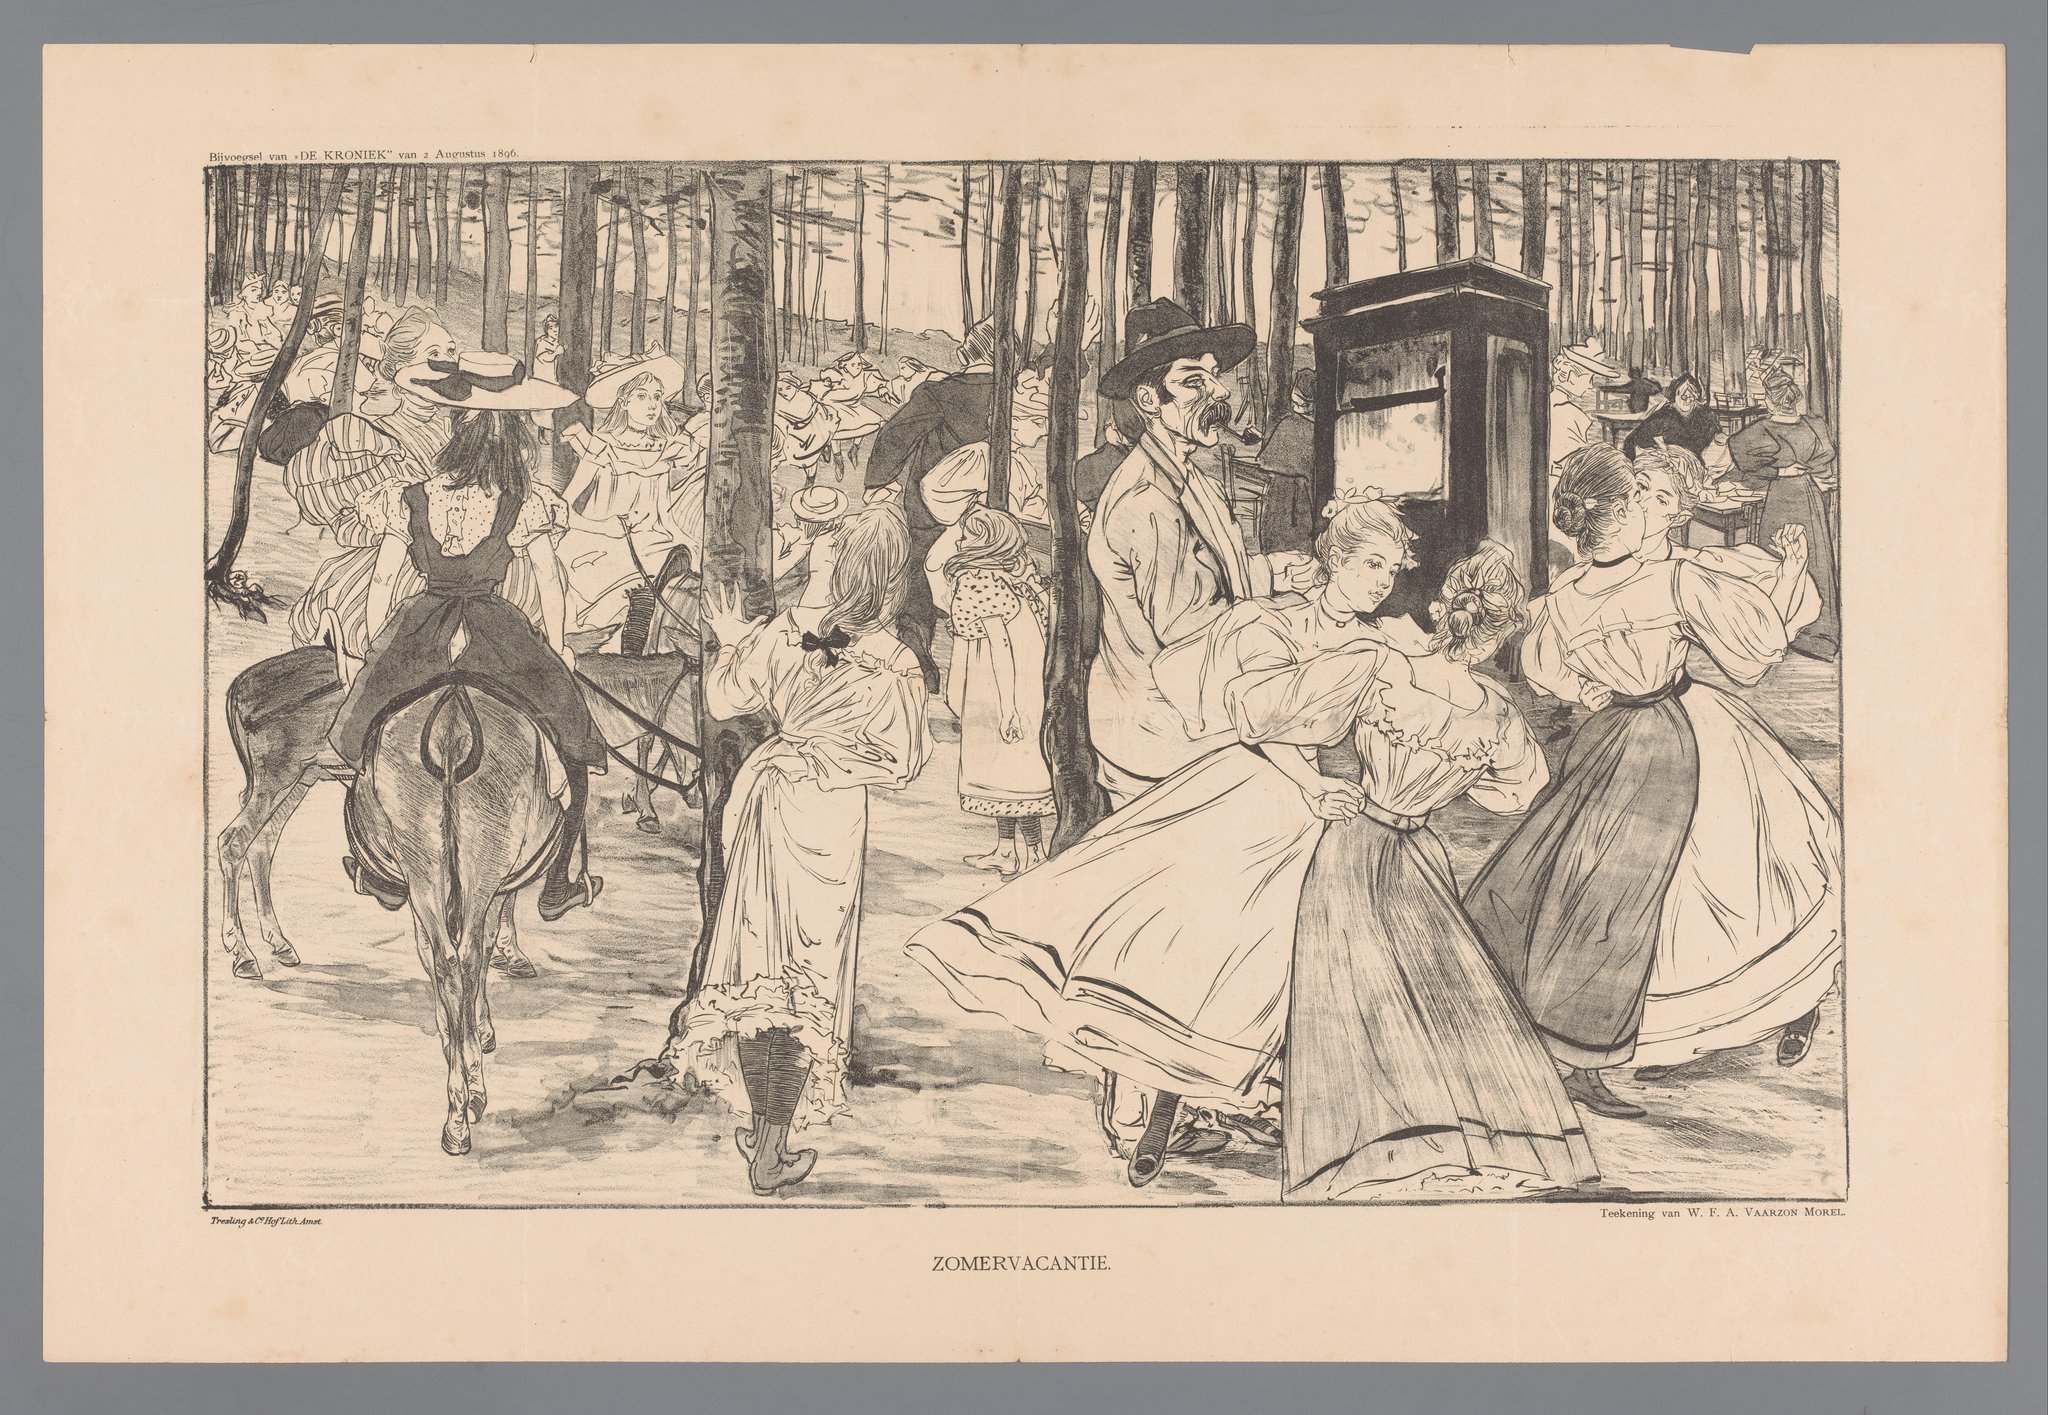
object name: cartoon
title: Zomervacantie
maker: willem vaarzon morel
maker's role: draughtsman, print maker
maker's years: 1868-1955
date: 1896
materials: paper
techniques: lithograph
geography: amsterdam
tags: forest, wood, summer landscape; landscape symbolizing summer (the four seasons of the year), netherlands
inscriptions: date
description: Prent met titel en onderschrift, bijvoegsel bij 'De Kroniek'. Gesigneerd en gedateerd.